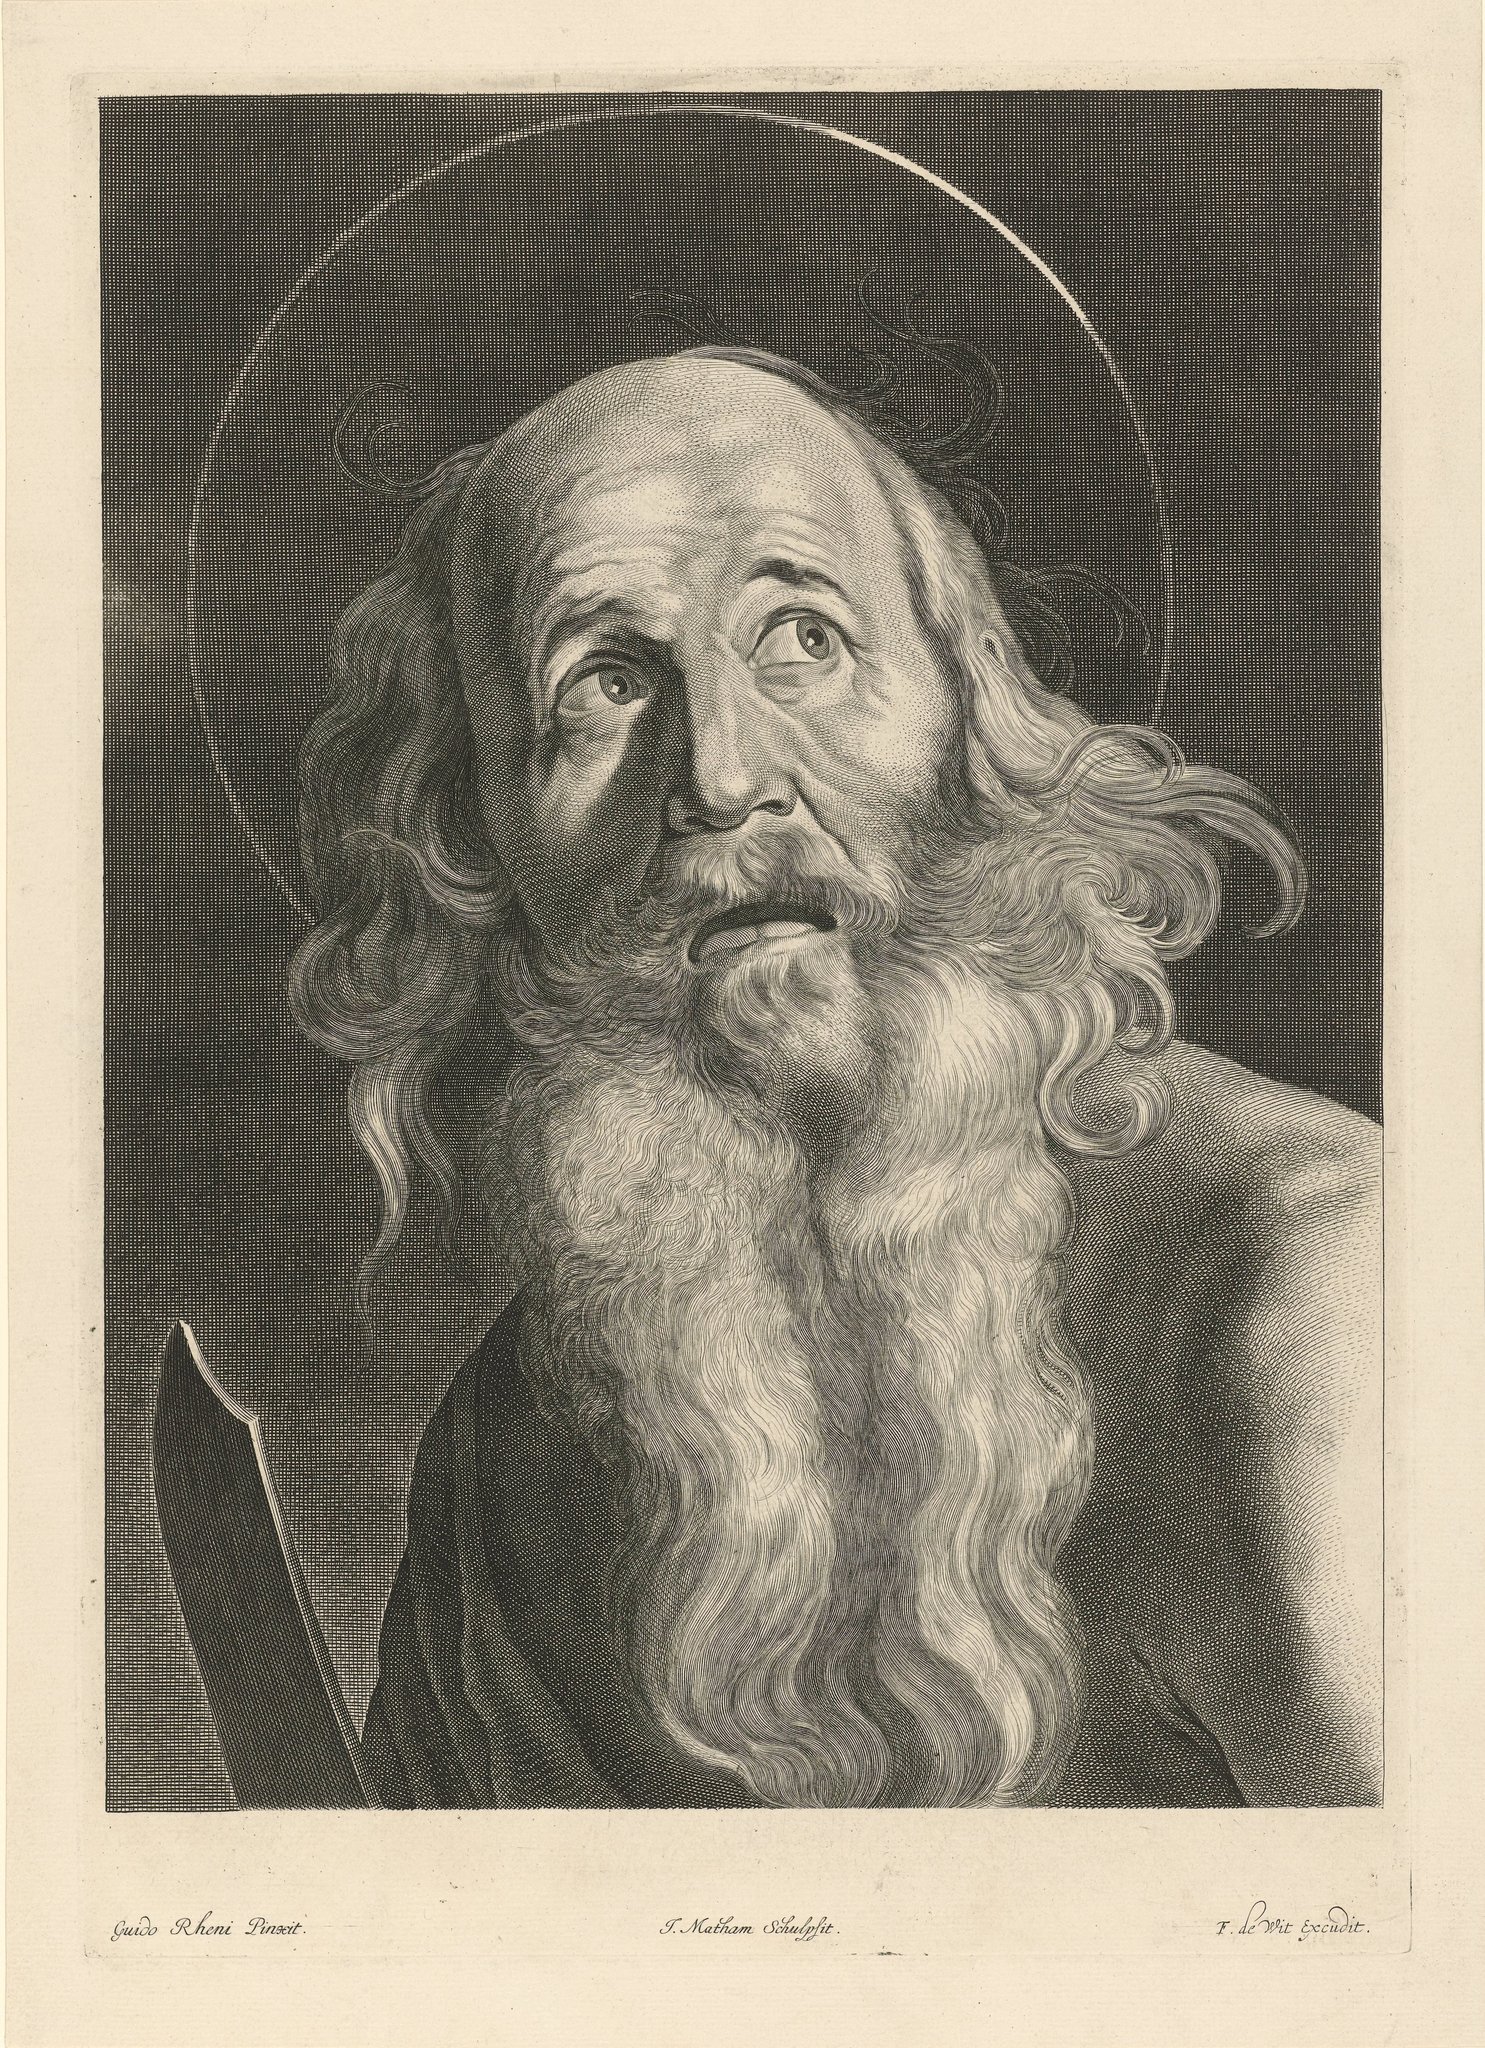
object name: print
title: H. Bartolomeus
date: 1630-1690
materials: paper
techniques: engraving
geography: amsterdam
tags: the apostle bartholomew; possible attributes: book, devil or dragon at feet, knife, scroll, flayed skin, staff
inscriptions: collector's mark: Lugt 2228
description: De heilige Bartolomeus, met geopende mond. In zijn hand een zwaard, dat gedeeltelijk te zien is.